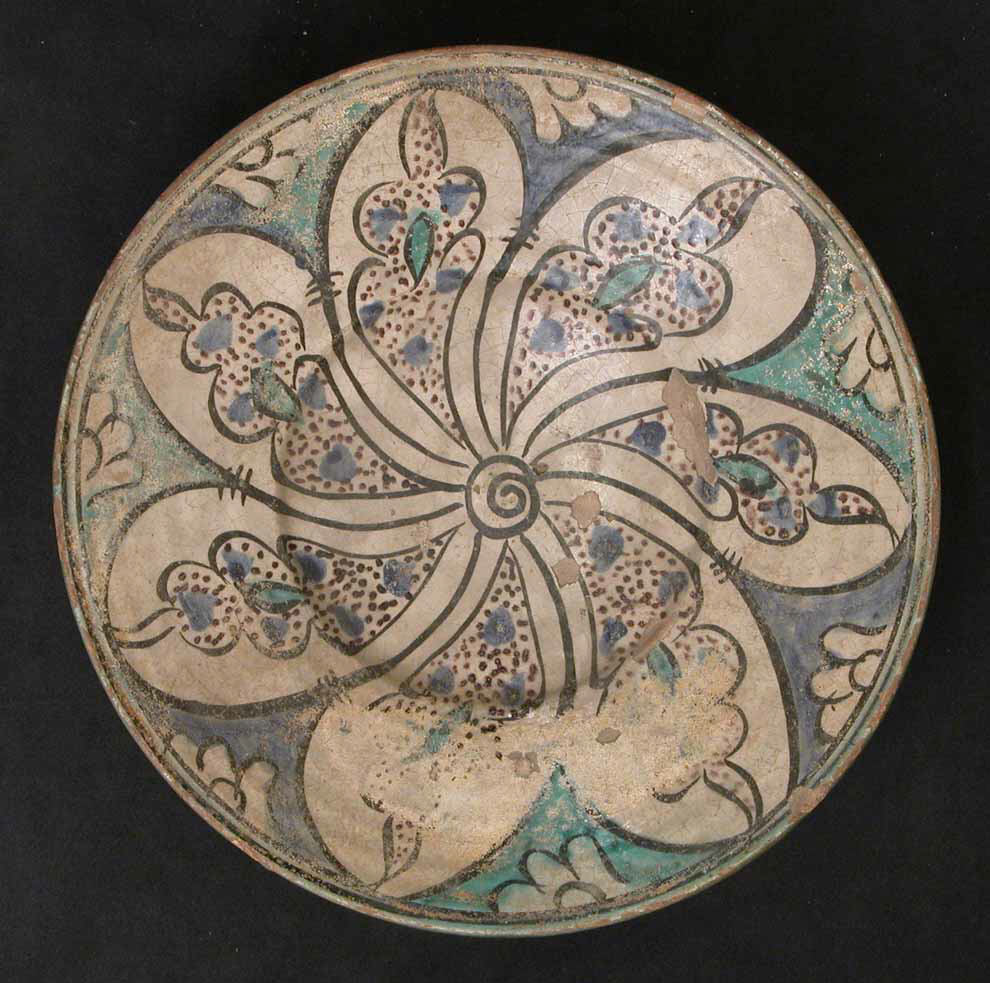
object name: plate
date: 901-1100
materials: earthenware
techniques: glazing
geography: iran